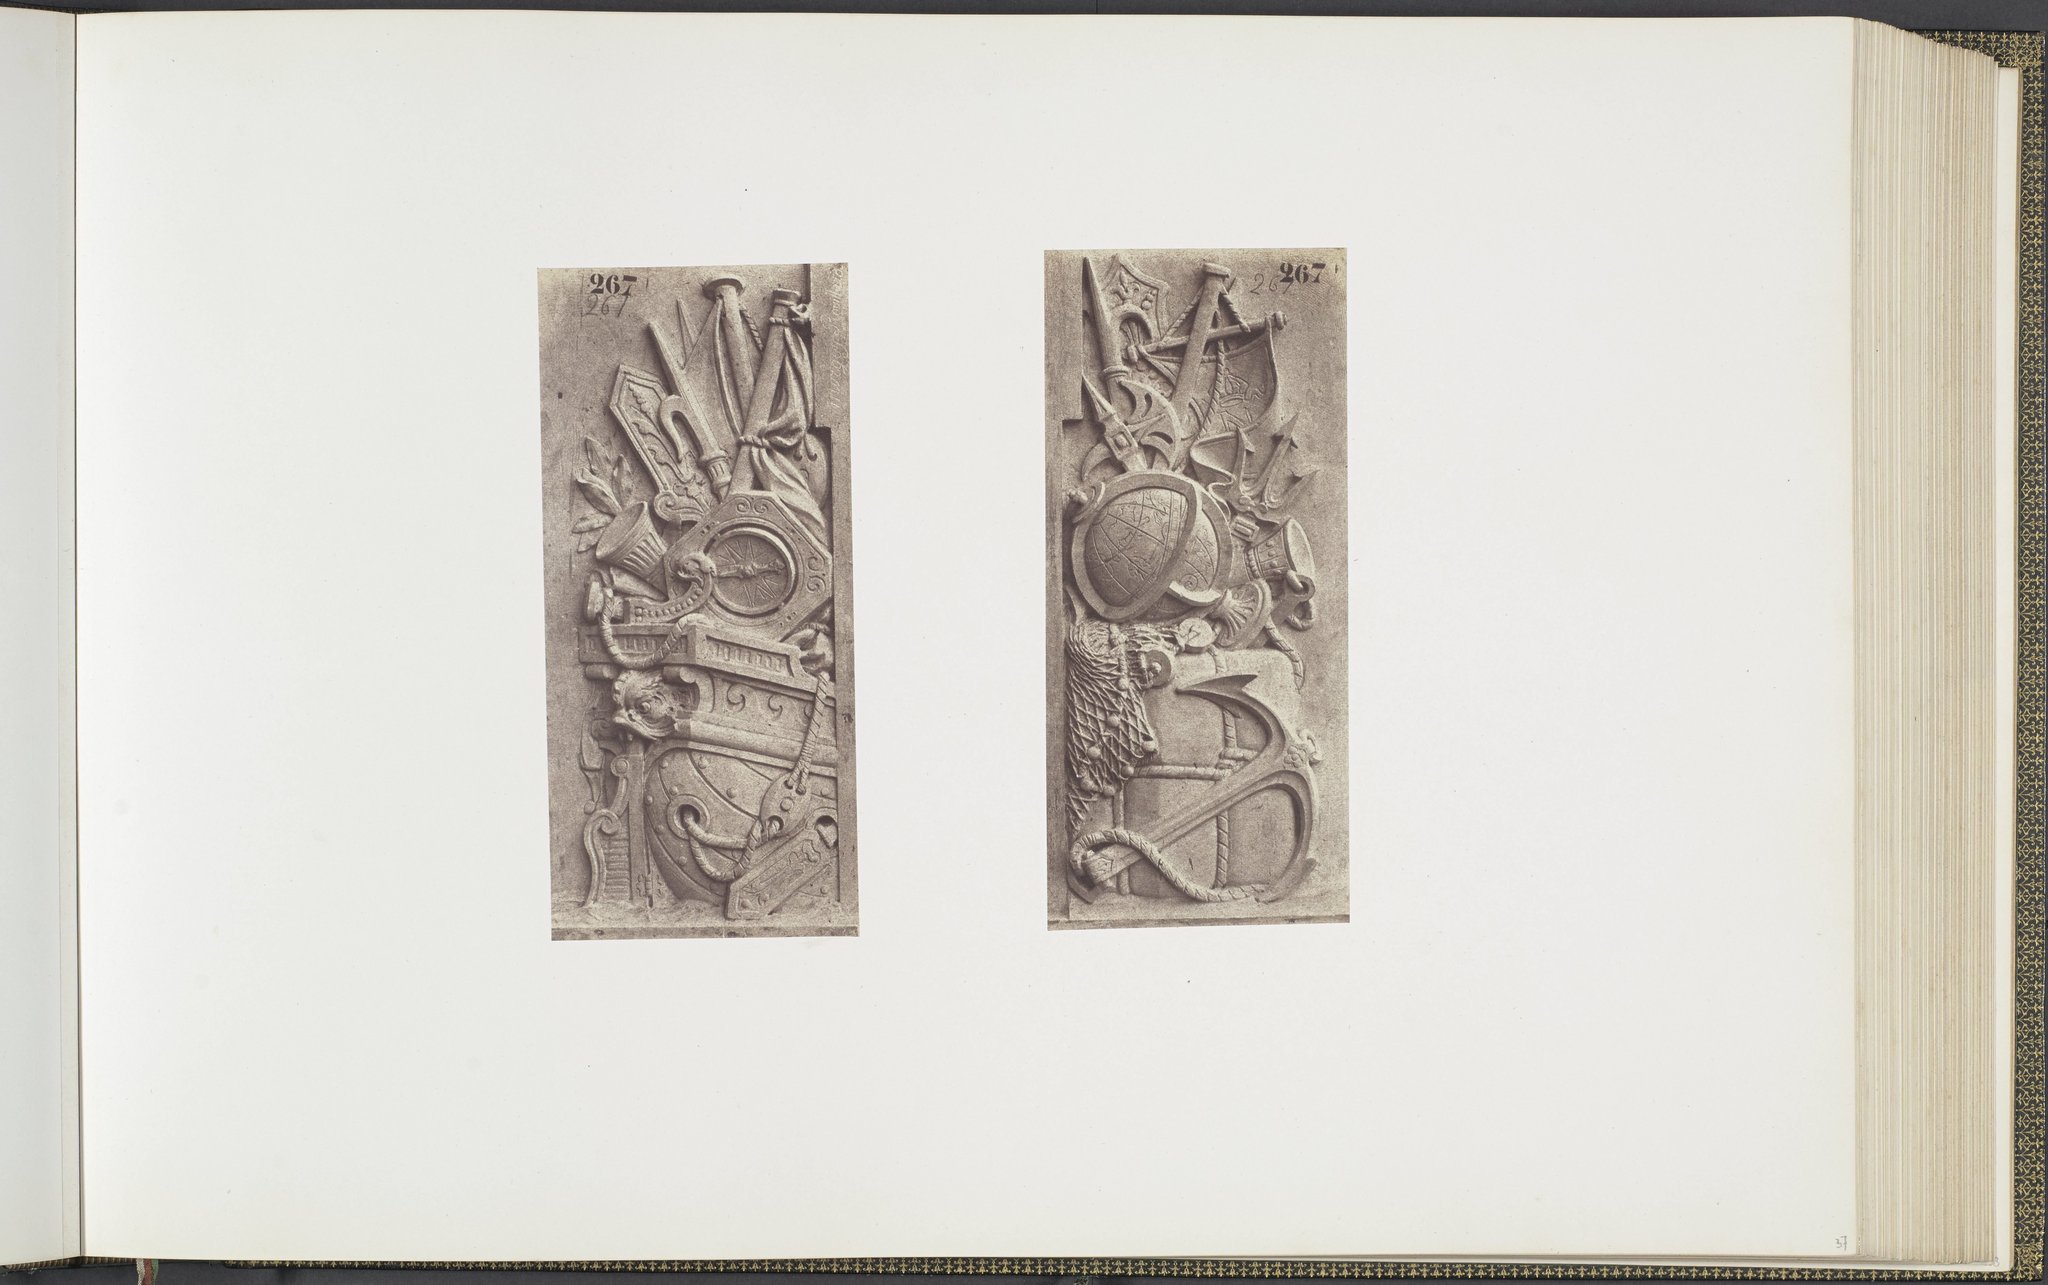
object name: photograph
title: Gipsmodellen voor beeldhouwwerken op het Palais du Louvre: links "Trophée maritime en rechts "Trophées" door Pierre Rouillard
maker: édouard denis baldus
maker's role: fotograaf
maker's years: 1813-1889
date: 1855-1857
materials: paper, photographic support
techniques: salted paper print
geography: paris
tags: piece of sculpture, reproduction of a piece of sculpture, permanent exhibition, museum, paris, tuileries palace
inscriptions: number: ‘267’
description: Onderdeel van Réunion des Tuileries au Louvre 1852-1857, album 1.